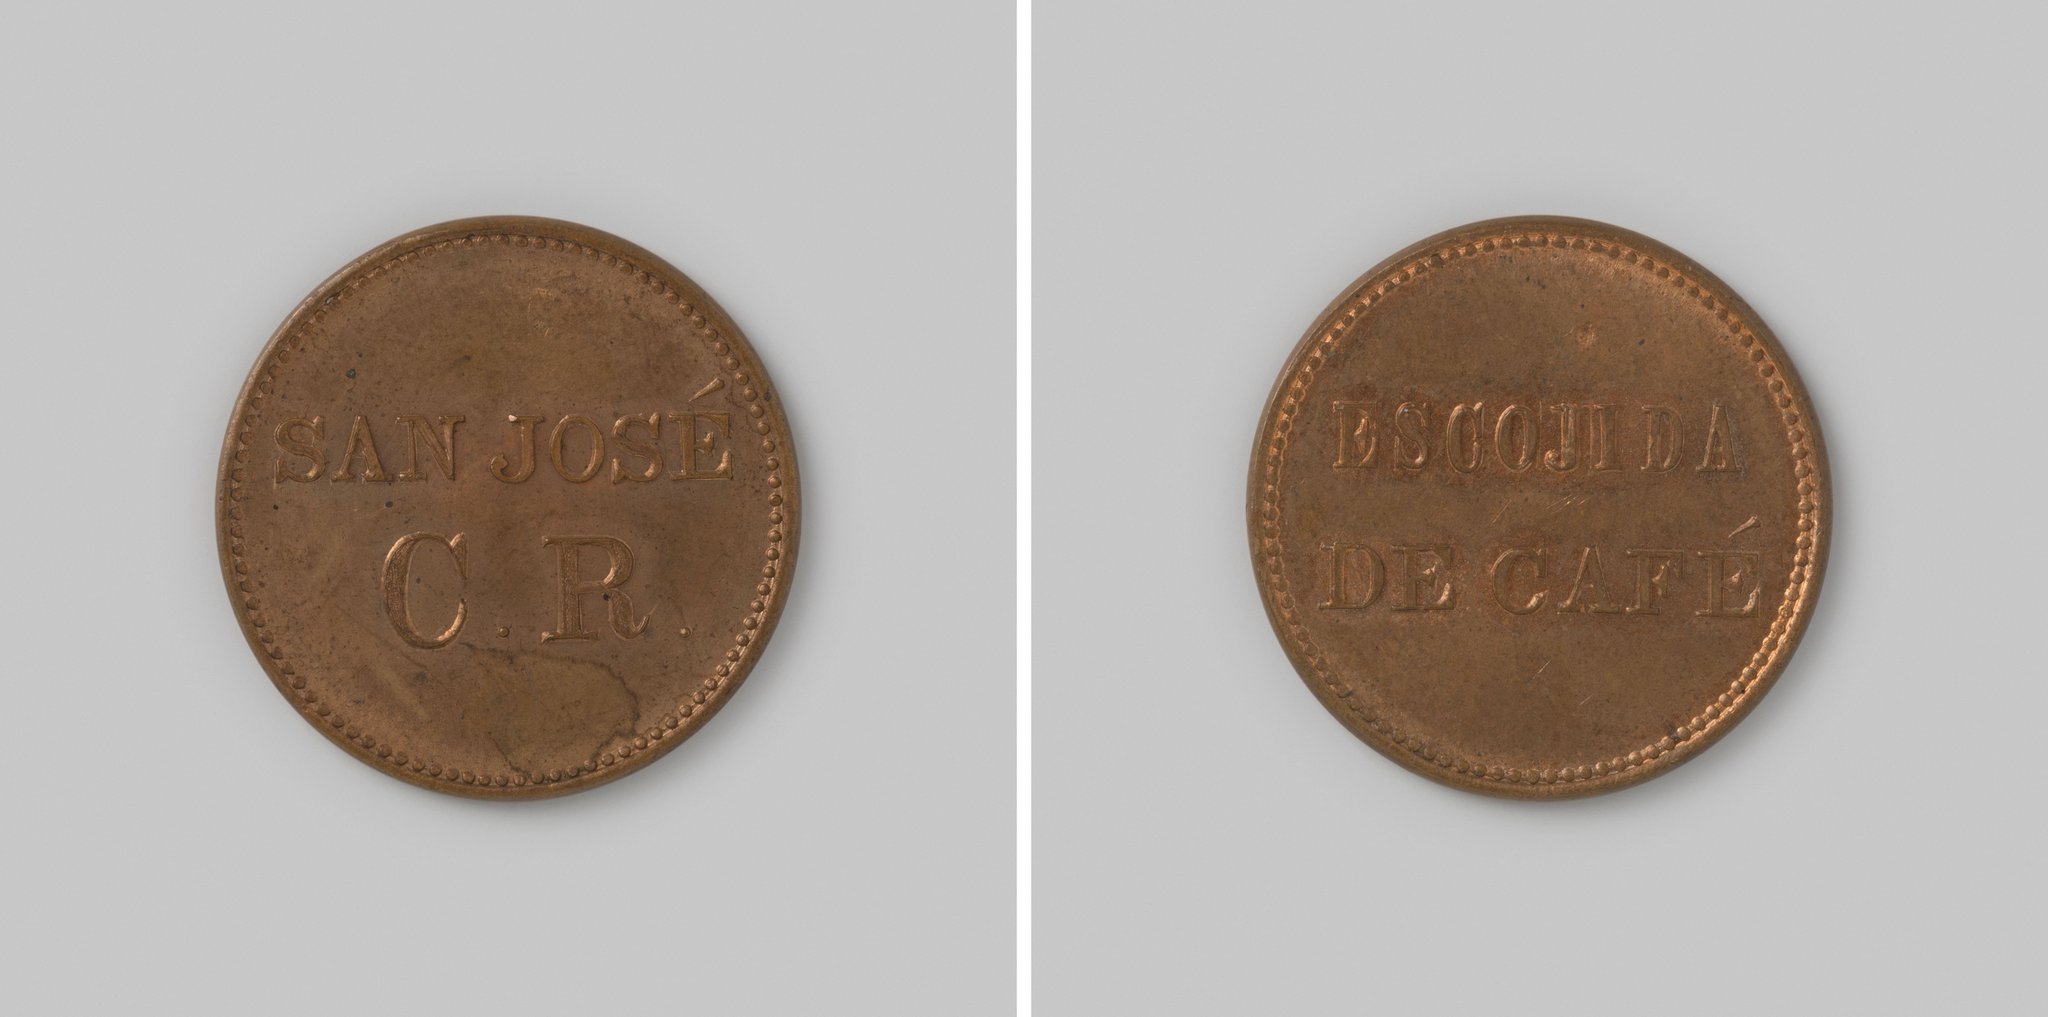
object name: real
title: Particuliere munt van 1 reaal op naam van San José C.R. [=Costa Rica]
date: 1800-1900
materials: copper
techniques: striking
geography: costa rica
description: Koperen particuliere munt, bestemd voor koffie. Voorzijde: firma-aanduiding. Keerzijde: in twee regels aanduiding voor de bestemming: Escojida de café. Gladde rand.